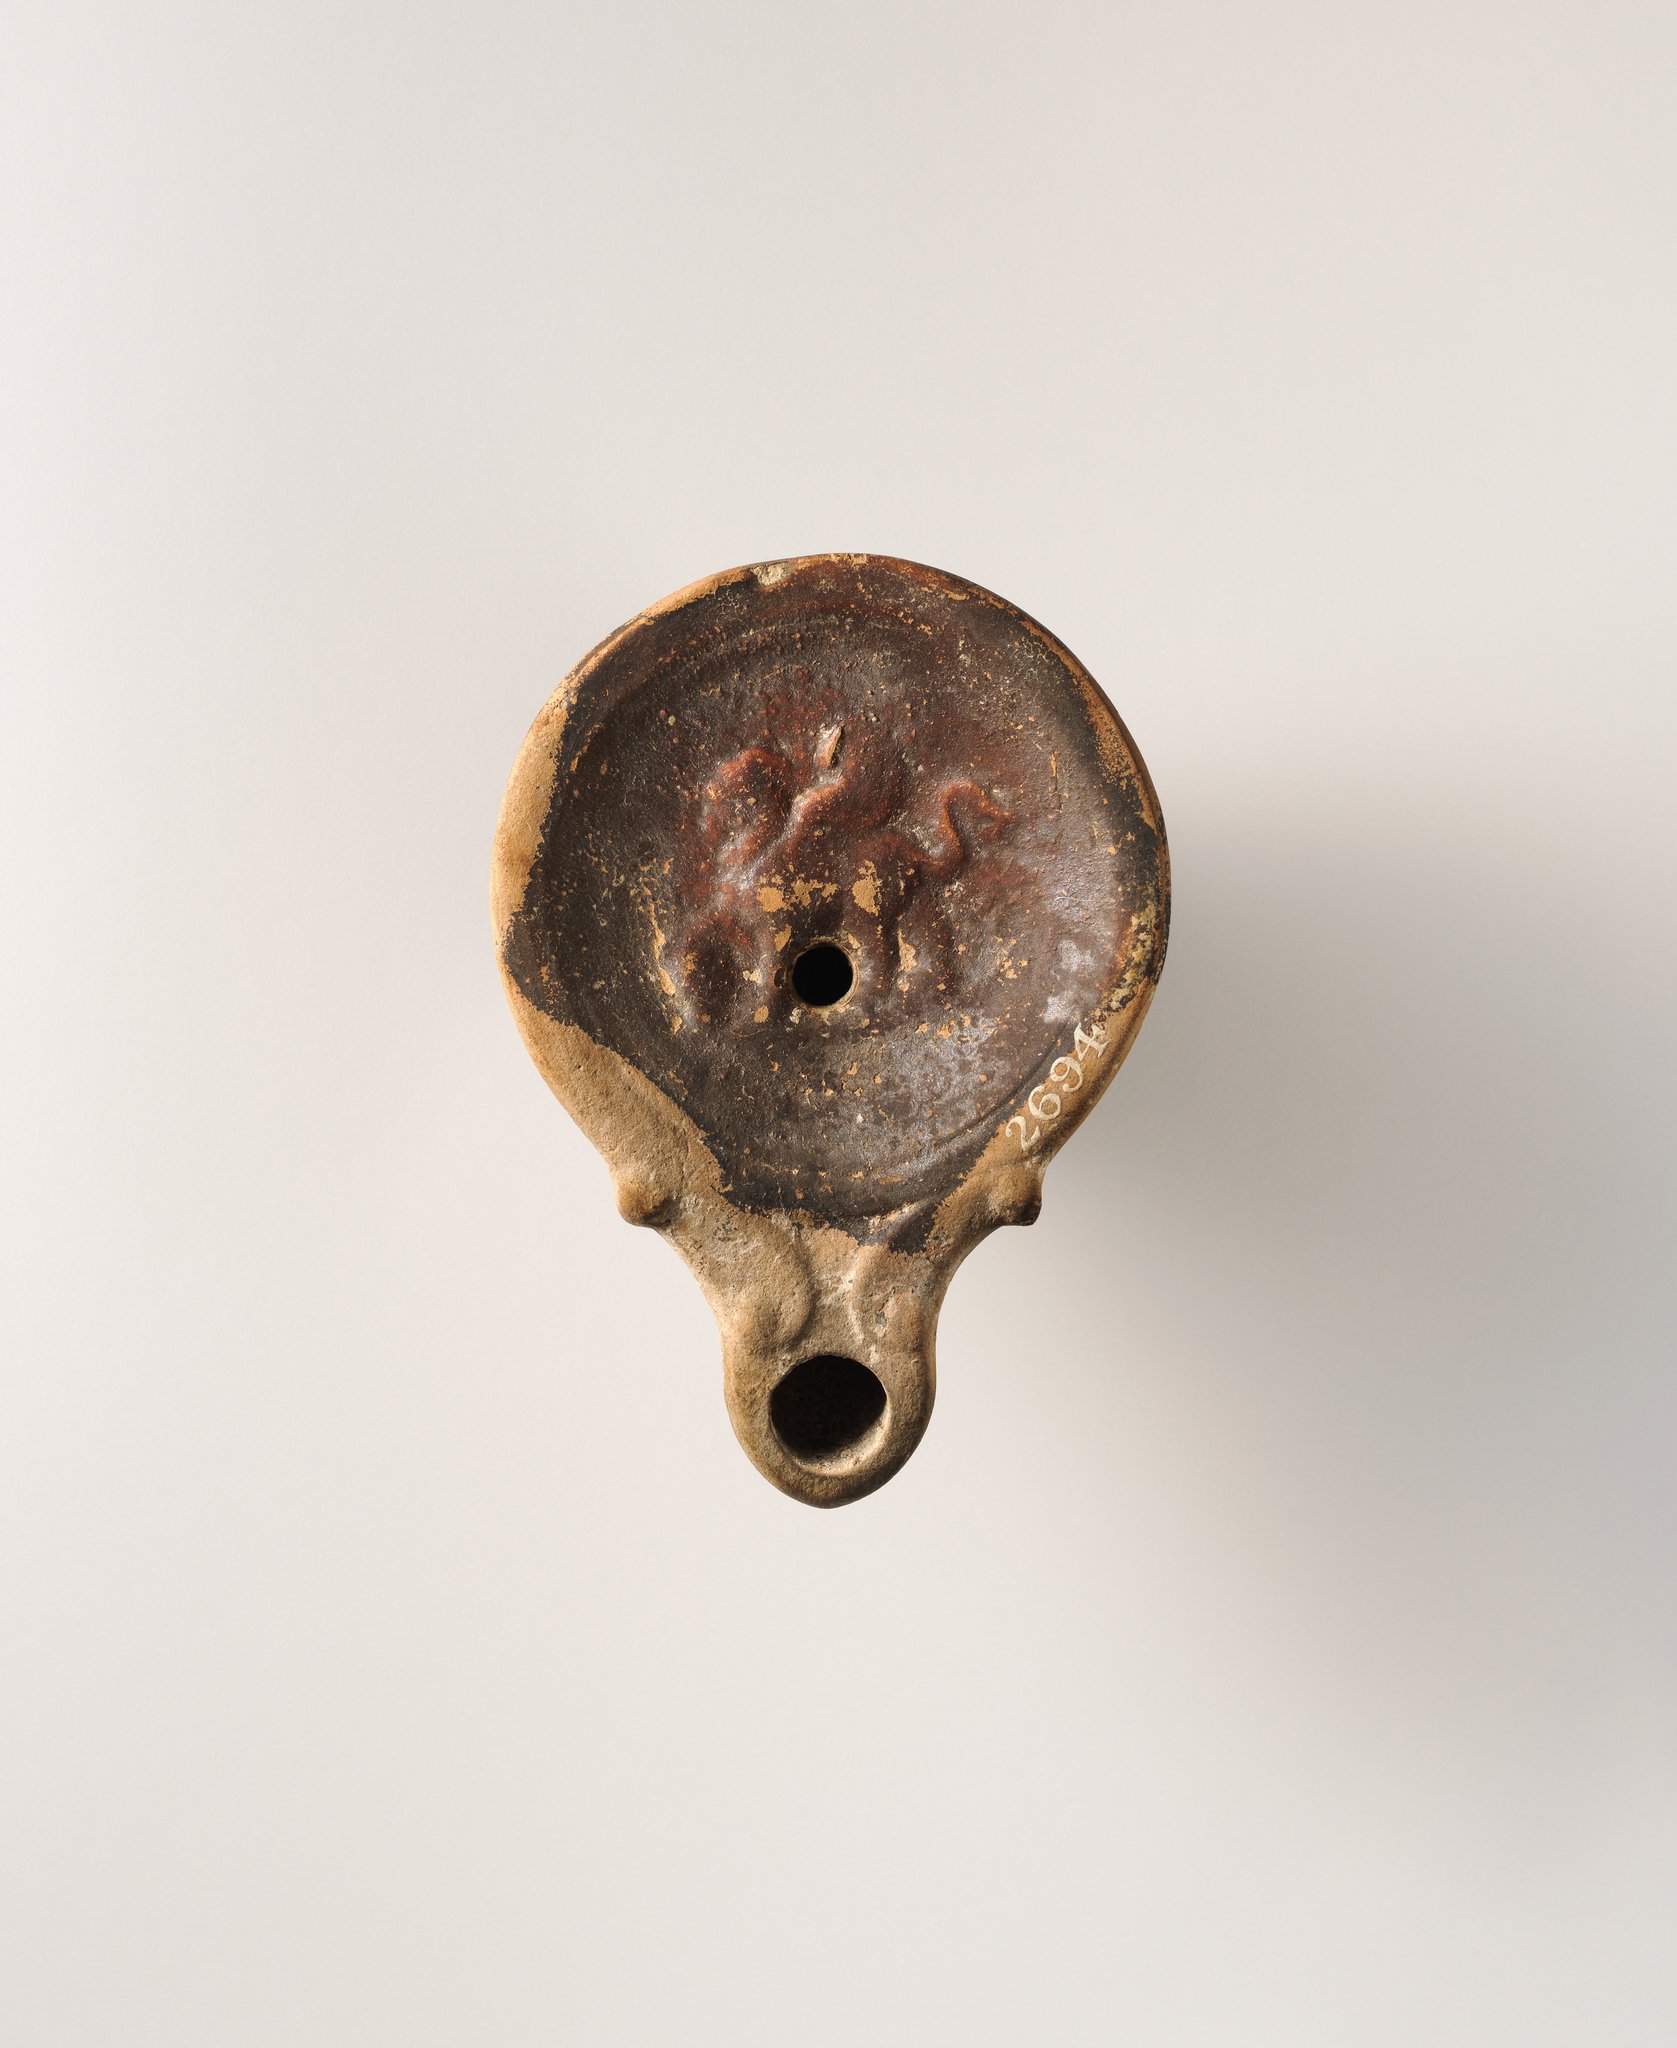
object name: lamp, concave top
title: Terracotta oil lamp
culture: roman, cypriot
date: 40-100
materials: terracotta